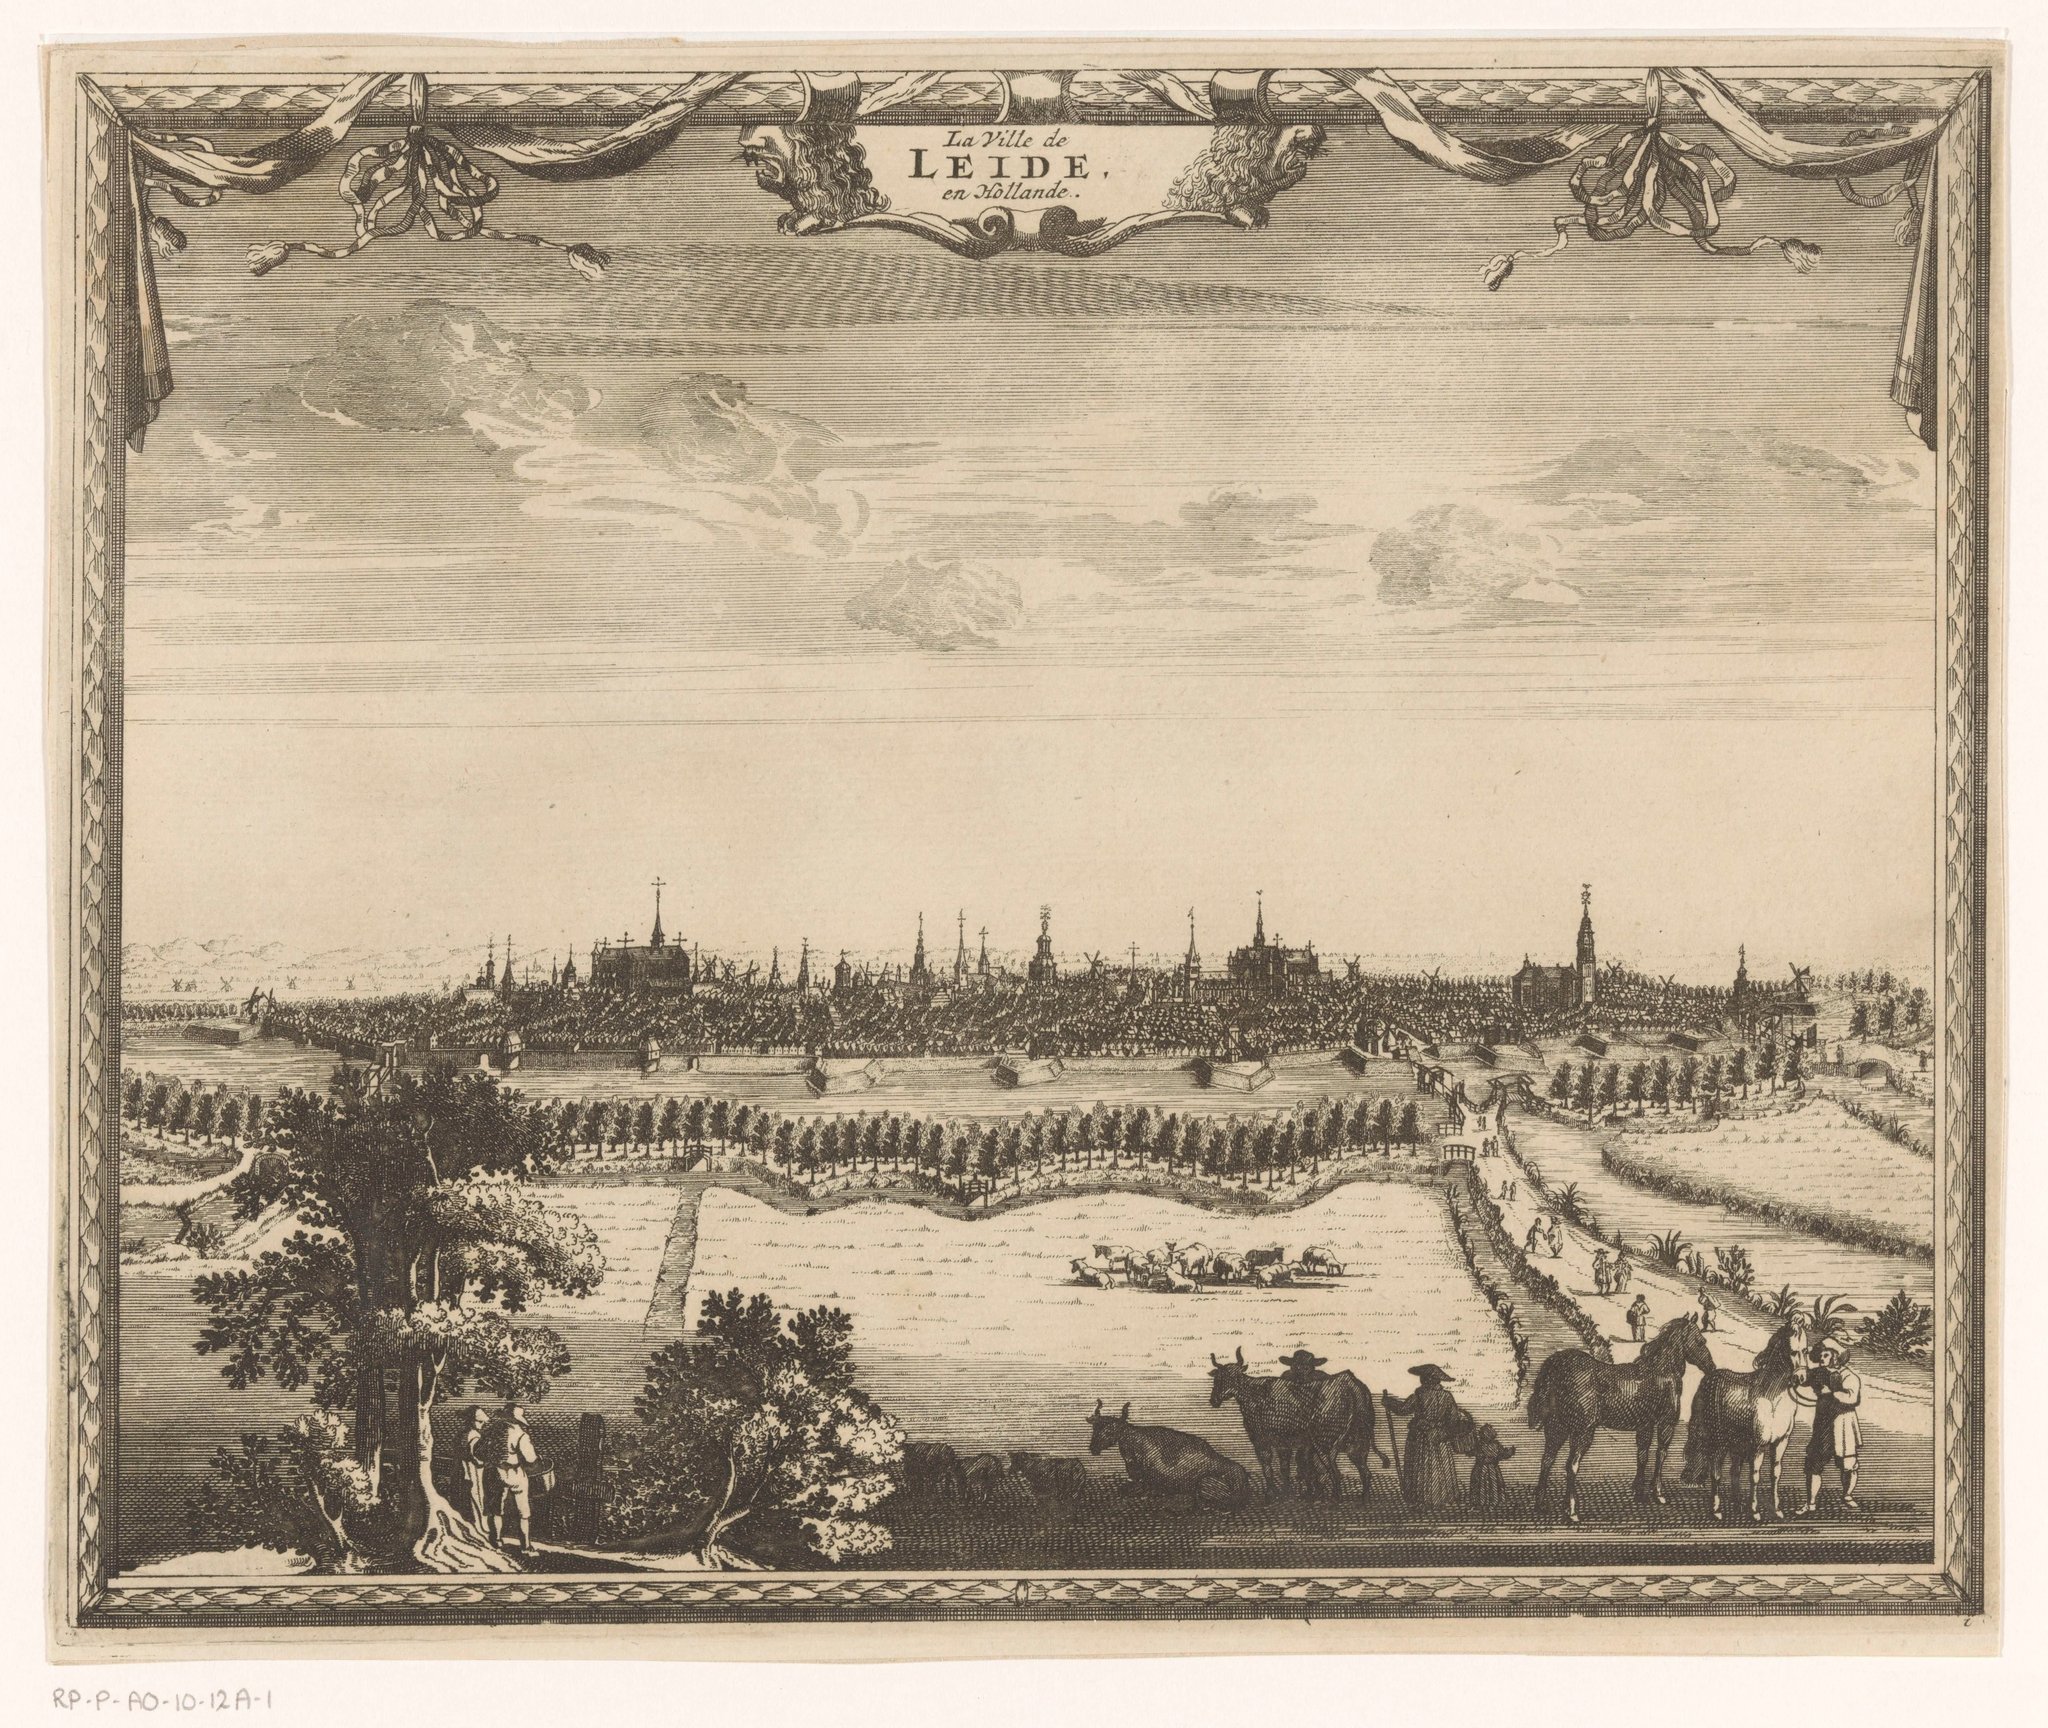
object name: print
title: Gezicht op Leiden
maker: Anonymous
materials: paper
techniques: etching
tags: prospect of city, town panorama, silhouette of city, leiden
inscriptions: collector's mark: Lugt 2228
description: Huidige staat van prent ook gebruikt in: Aa, Pieter van der. Europa. Leiden: Pieter van der Aa, s.a. [ca. 1715]. En in: Afbeeldinghe der voornaemste steeden van Nederlant / Les principales villes des Pais-bas. Amsteram: Covens & Mortier, s.a. [na 1721]. En in: Les forces de l'Europe, Asie, Afrique et Amerique, ou description des principales villes, avec leurs fortifications (…). 20 delen. Leiden : Pieter van der Aa, 1726. Huidige staat met apart gedrukte sierrand gebruikt in: Aa, Pieter van der. La galerie agreable du monde (...). 66 delen. Leiden: Pieter van der Aa, 1728, dl. 18. Voor eerdere staat zie: RP-P-AO-10-12.